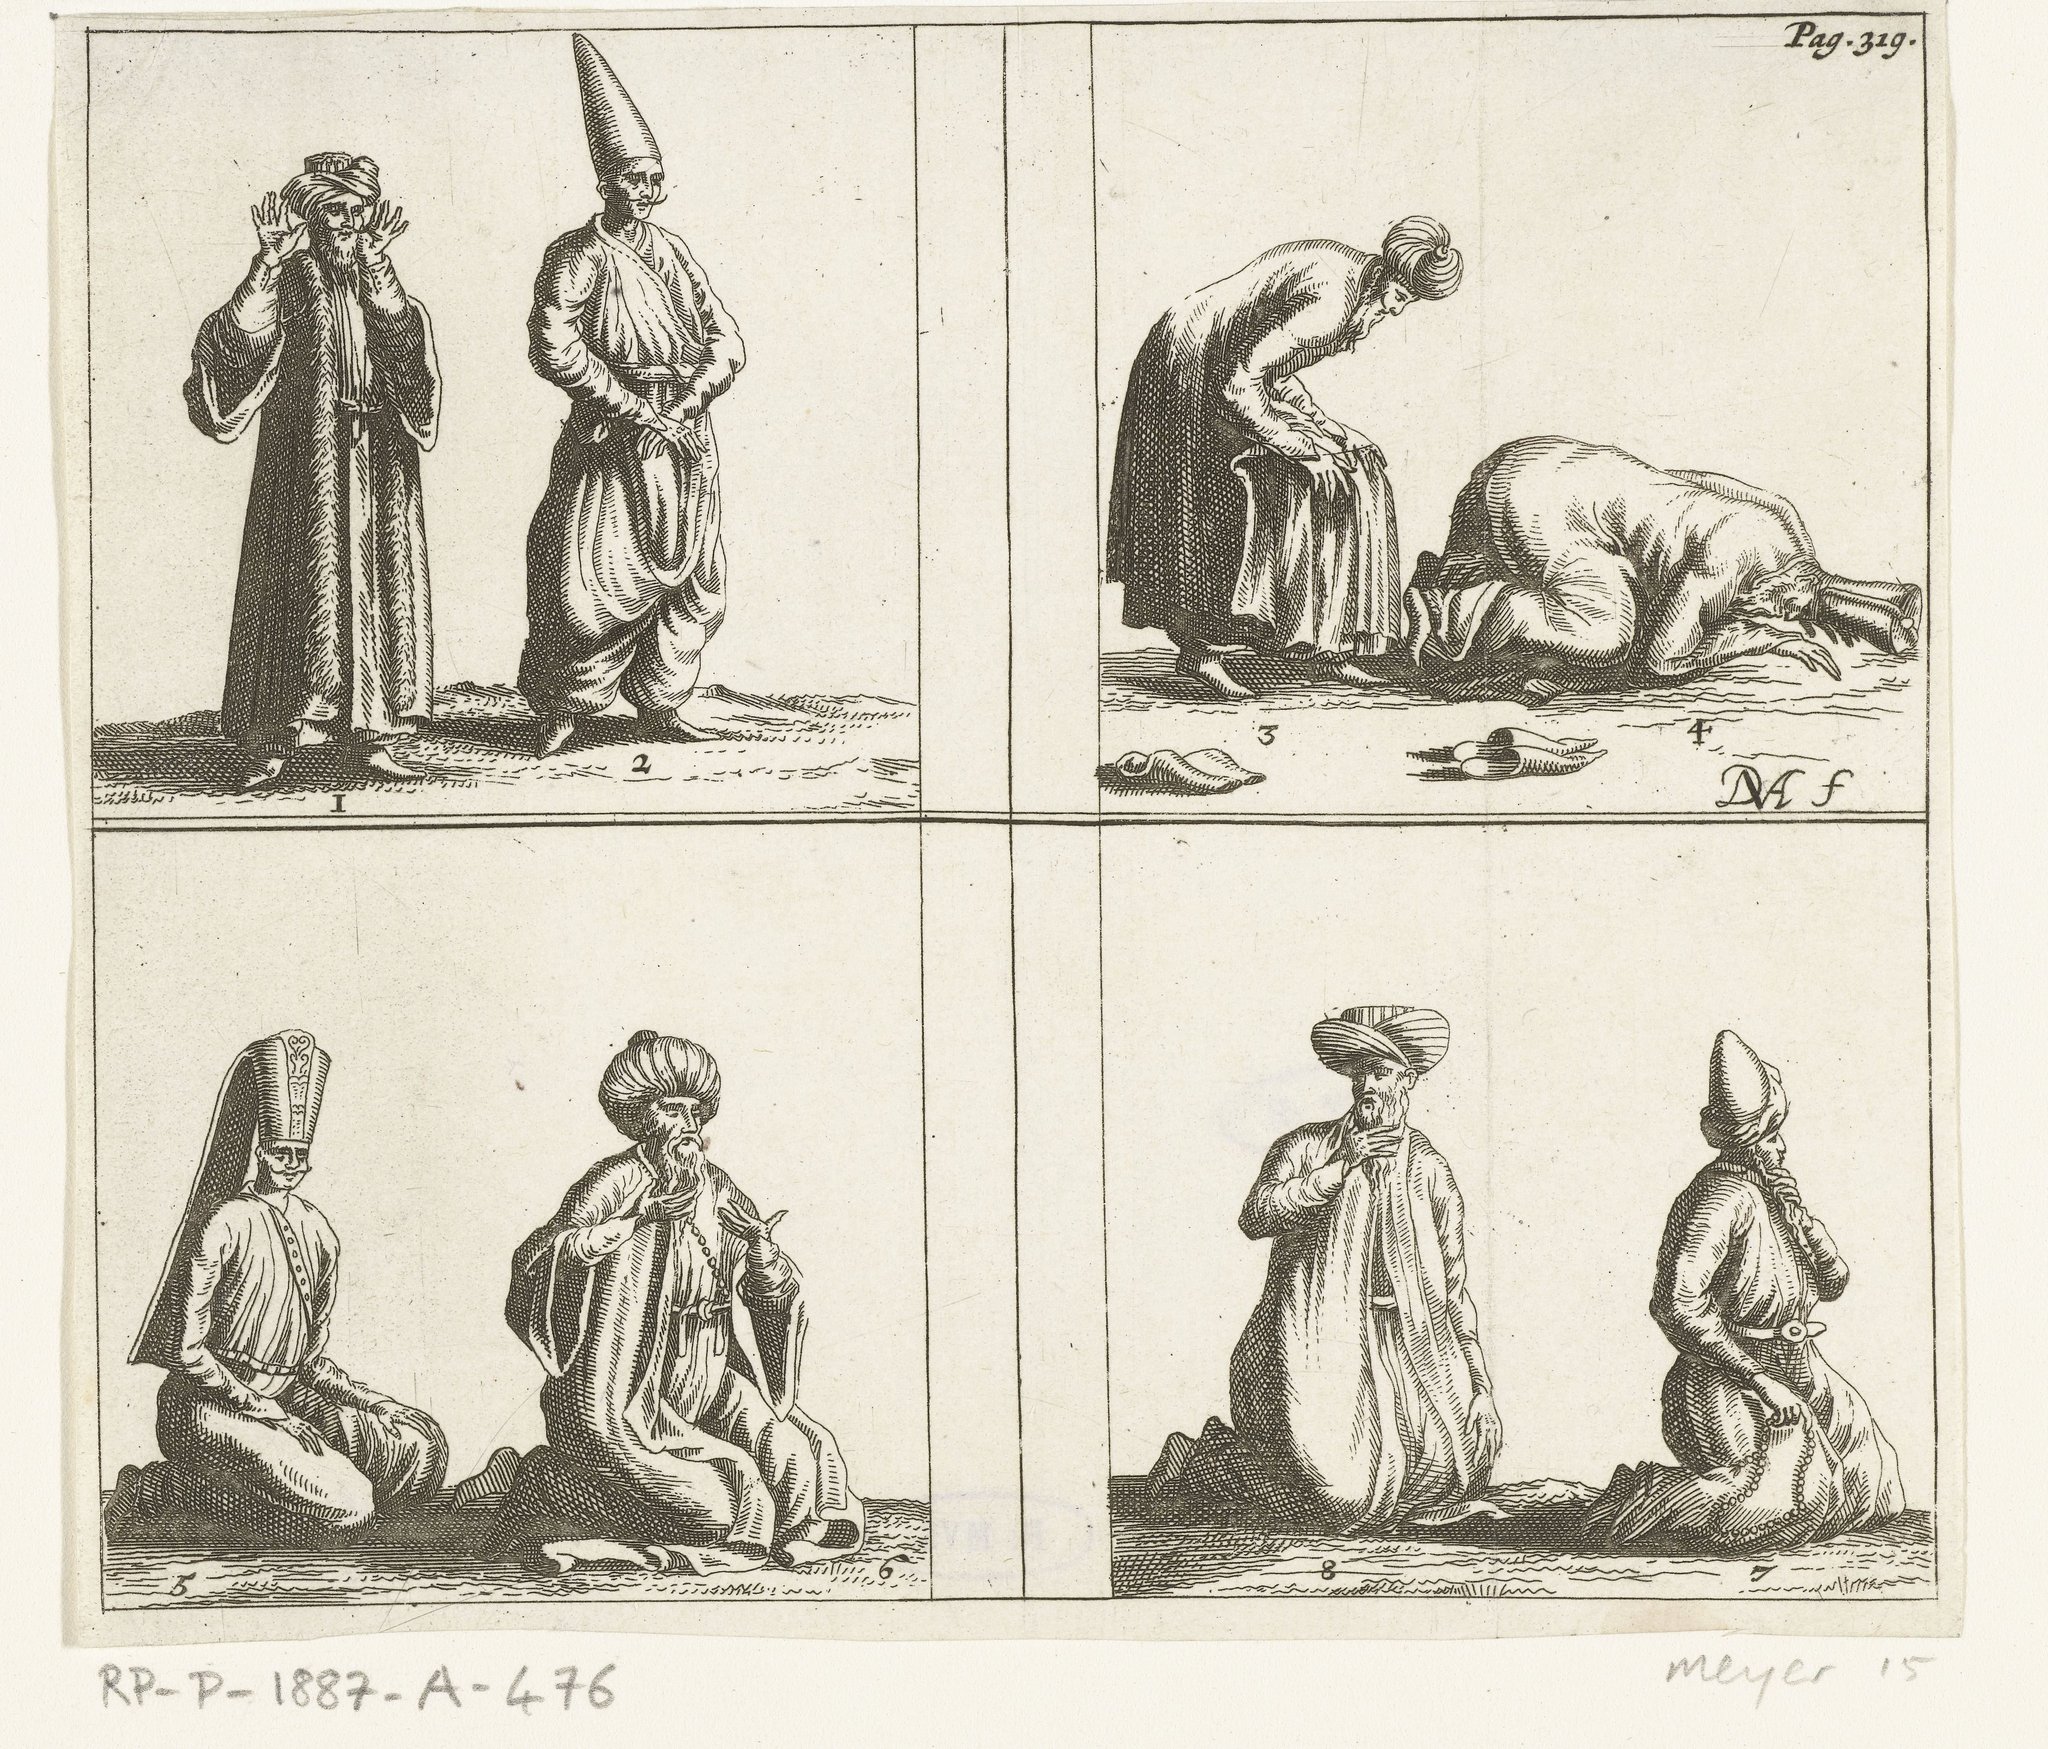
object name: print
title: Moslims in verschillende gebedshoudingen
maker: johannes jacobsz van den aveele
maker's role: print maker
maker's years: 1655-1727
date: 1681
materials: paper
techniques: etching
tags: prayer ~ islam, mohammedanism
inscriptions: collector's mark: Lugt 2228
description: illustratie voor: Guillaume Grelot, Relation nouvelle d'un voyage de Constantinople. naar de kopie van: Paris, P. Rocolet, veuve D. Foucault, 1681